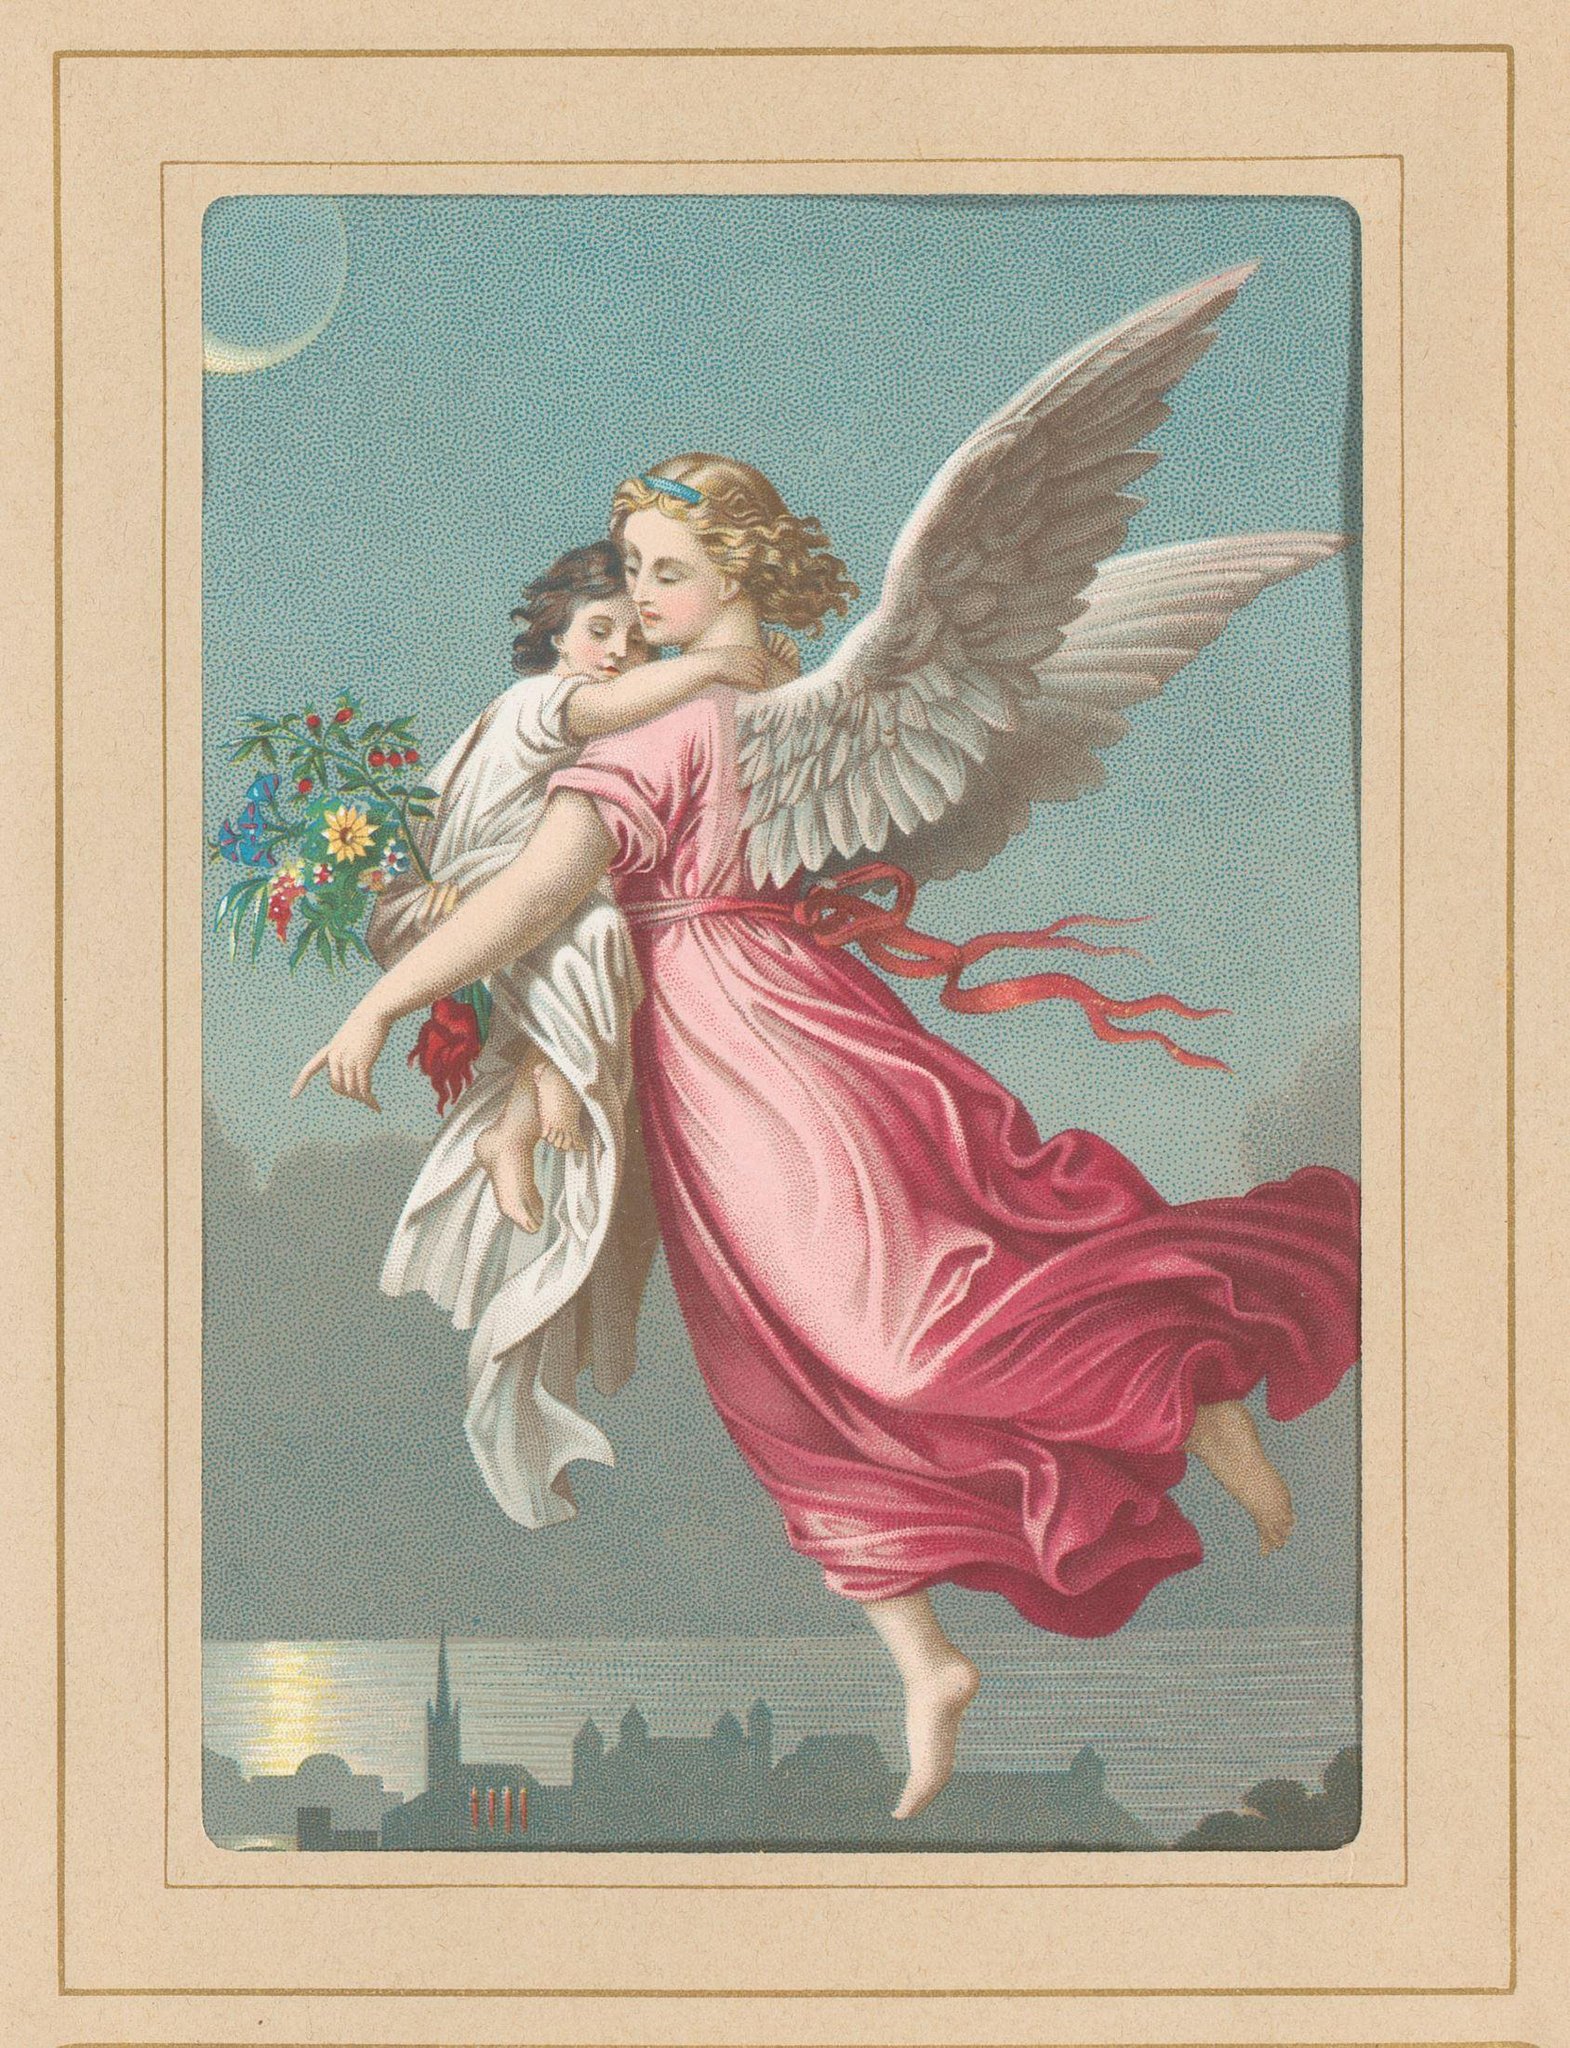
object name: album leaf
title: Kind gedragen door engel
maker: Anonymous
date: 1870-1900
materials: paper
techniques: collotype process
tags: child, angels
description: Deze prent maakt deel uit van een album.